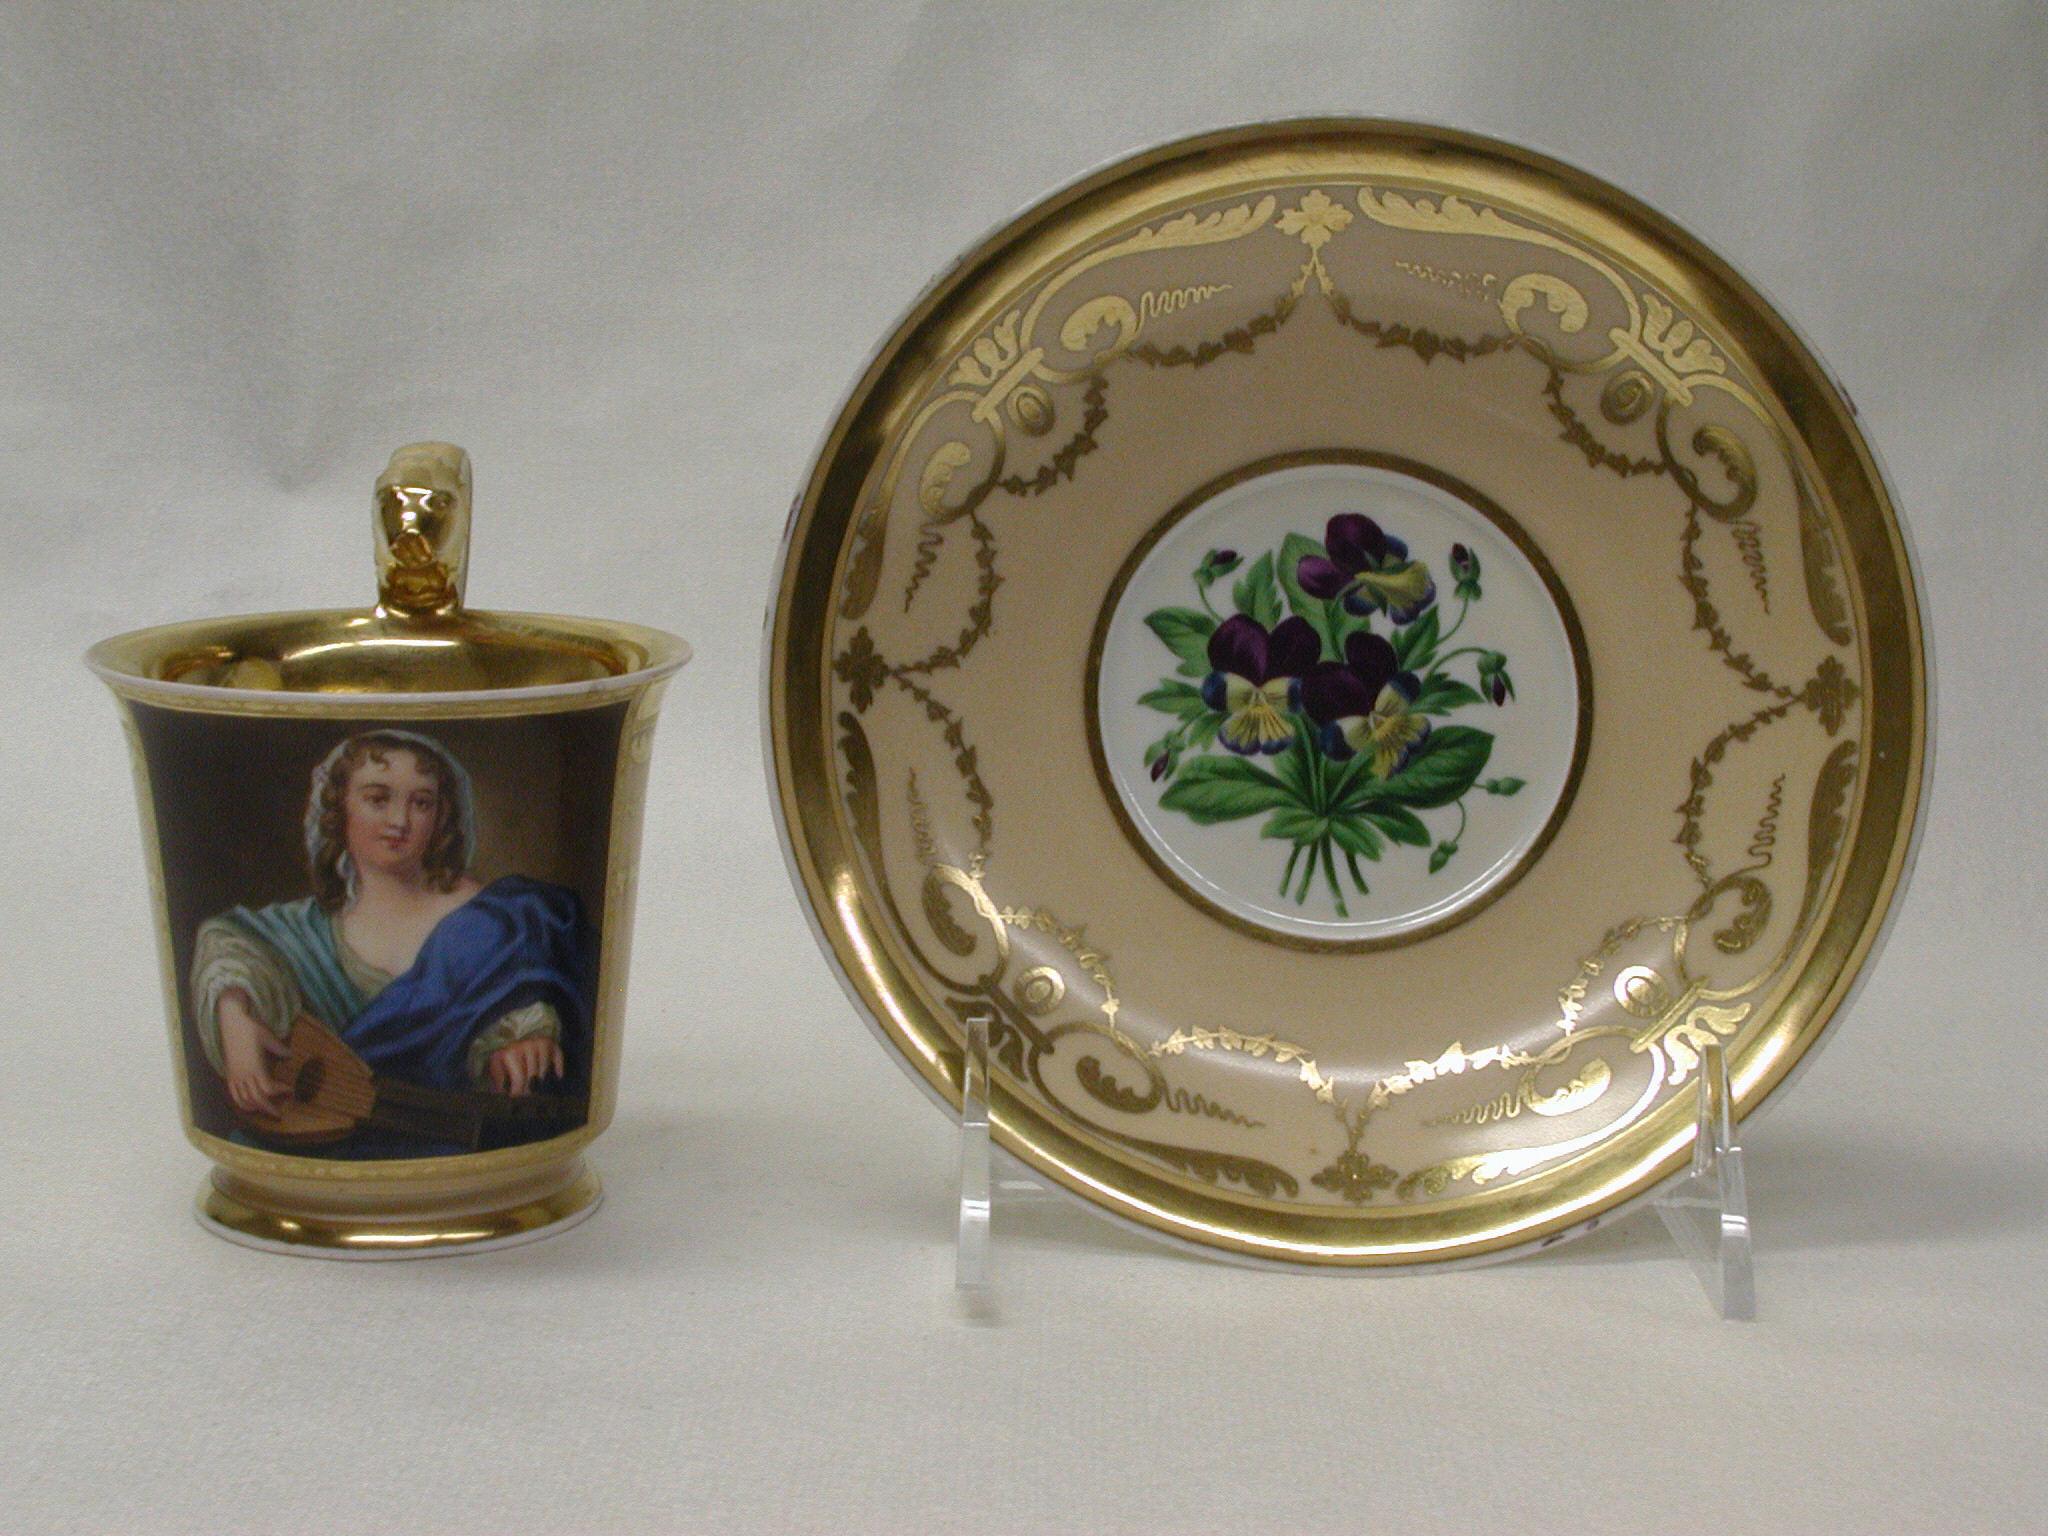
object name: cup and saucer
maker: vienna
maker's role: manufactory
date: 1870-1880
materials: gilt, hard paste porcelain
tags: portraits,women,flowers